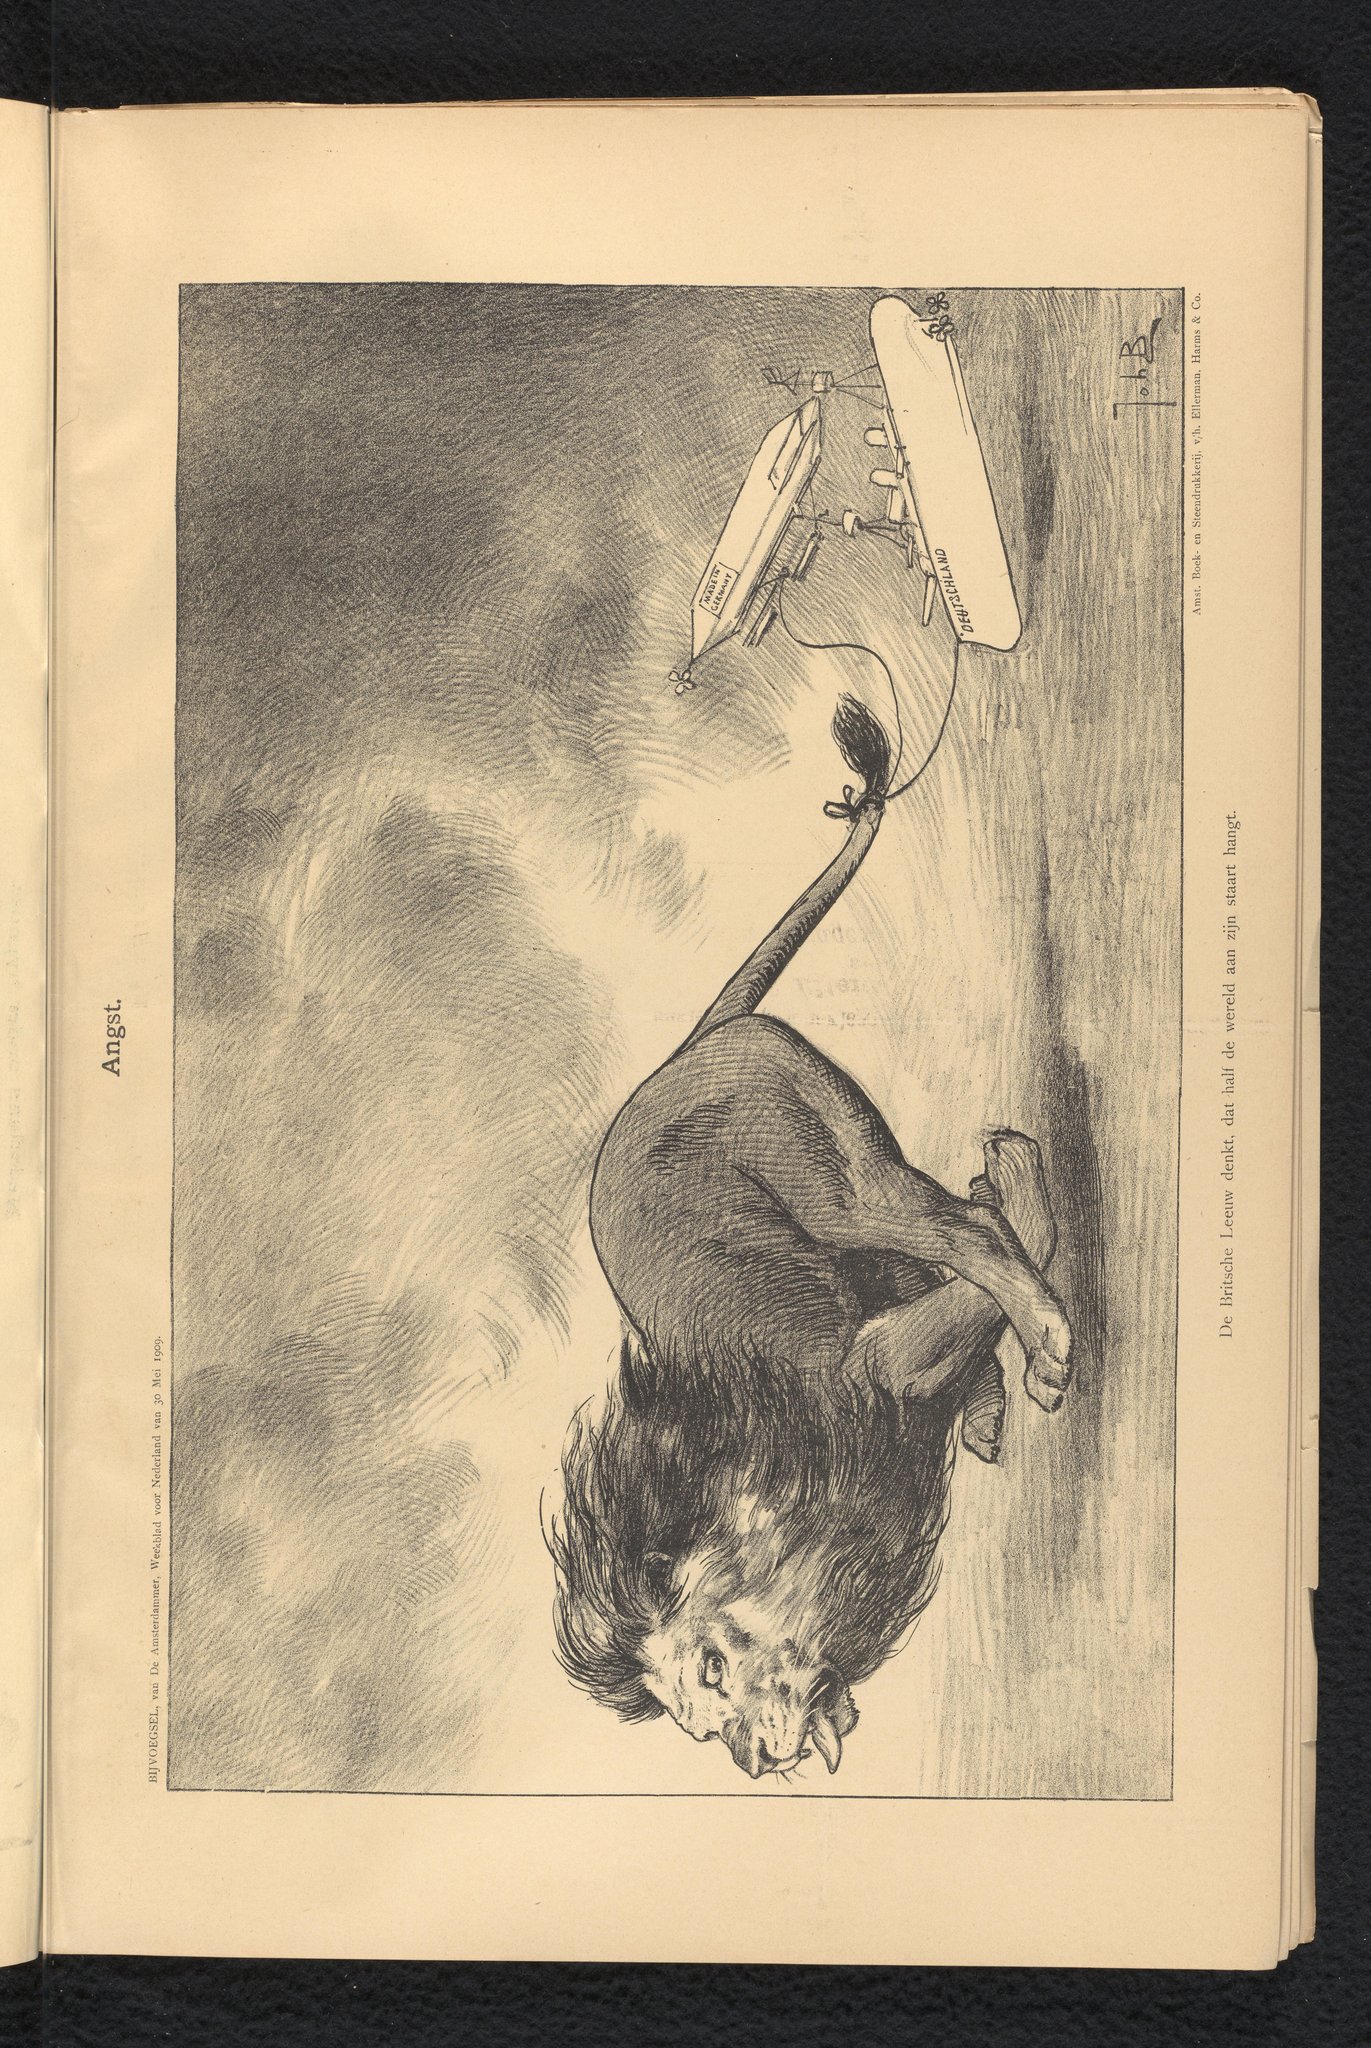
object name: cartoon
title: Angst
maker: johan braakensiek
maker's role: draughtsman, print maker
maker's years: 1858-1940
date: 1909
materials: paper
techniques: lithograph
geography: netherlands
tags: personifications of countries, nations, states, districts, etc., 46c35 airship, zeppelin, beasts of prey, predatory animals: lion, political caricatures and satires, steamship, motorship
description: De Britse leeuw holt bang weg met een Duits luchtschip en oorlogsschip aan zijn staart gebonden.